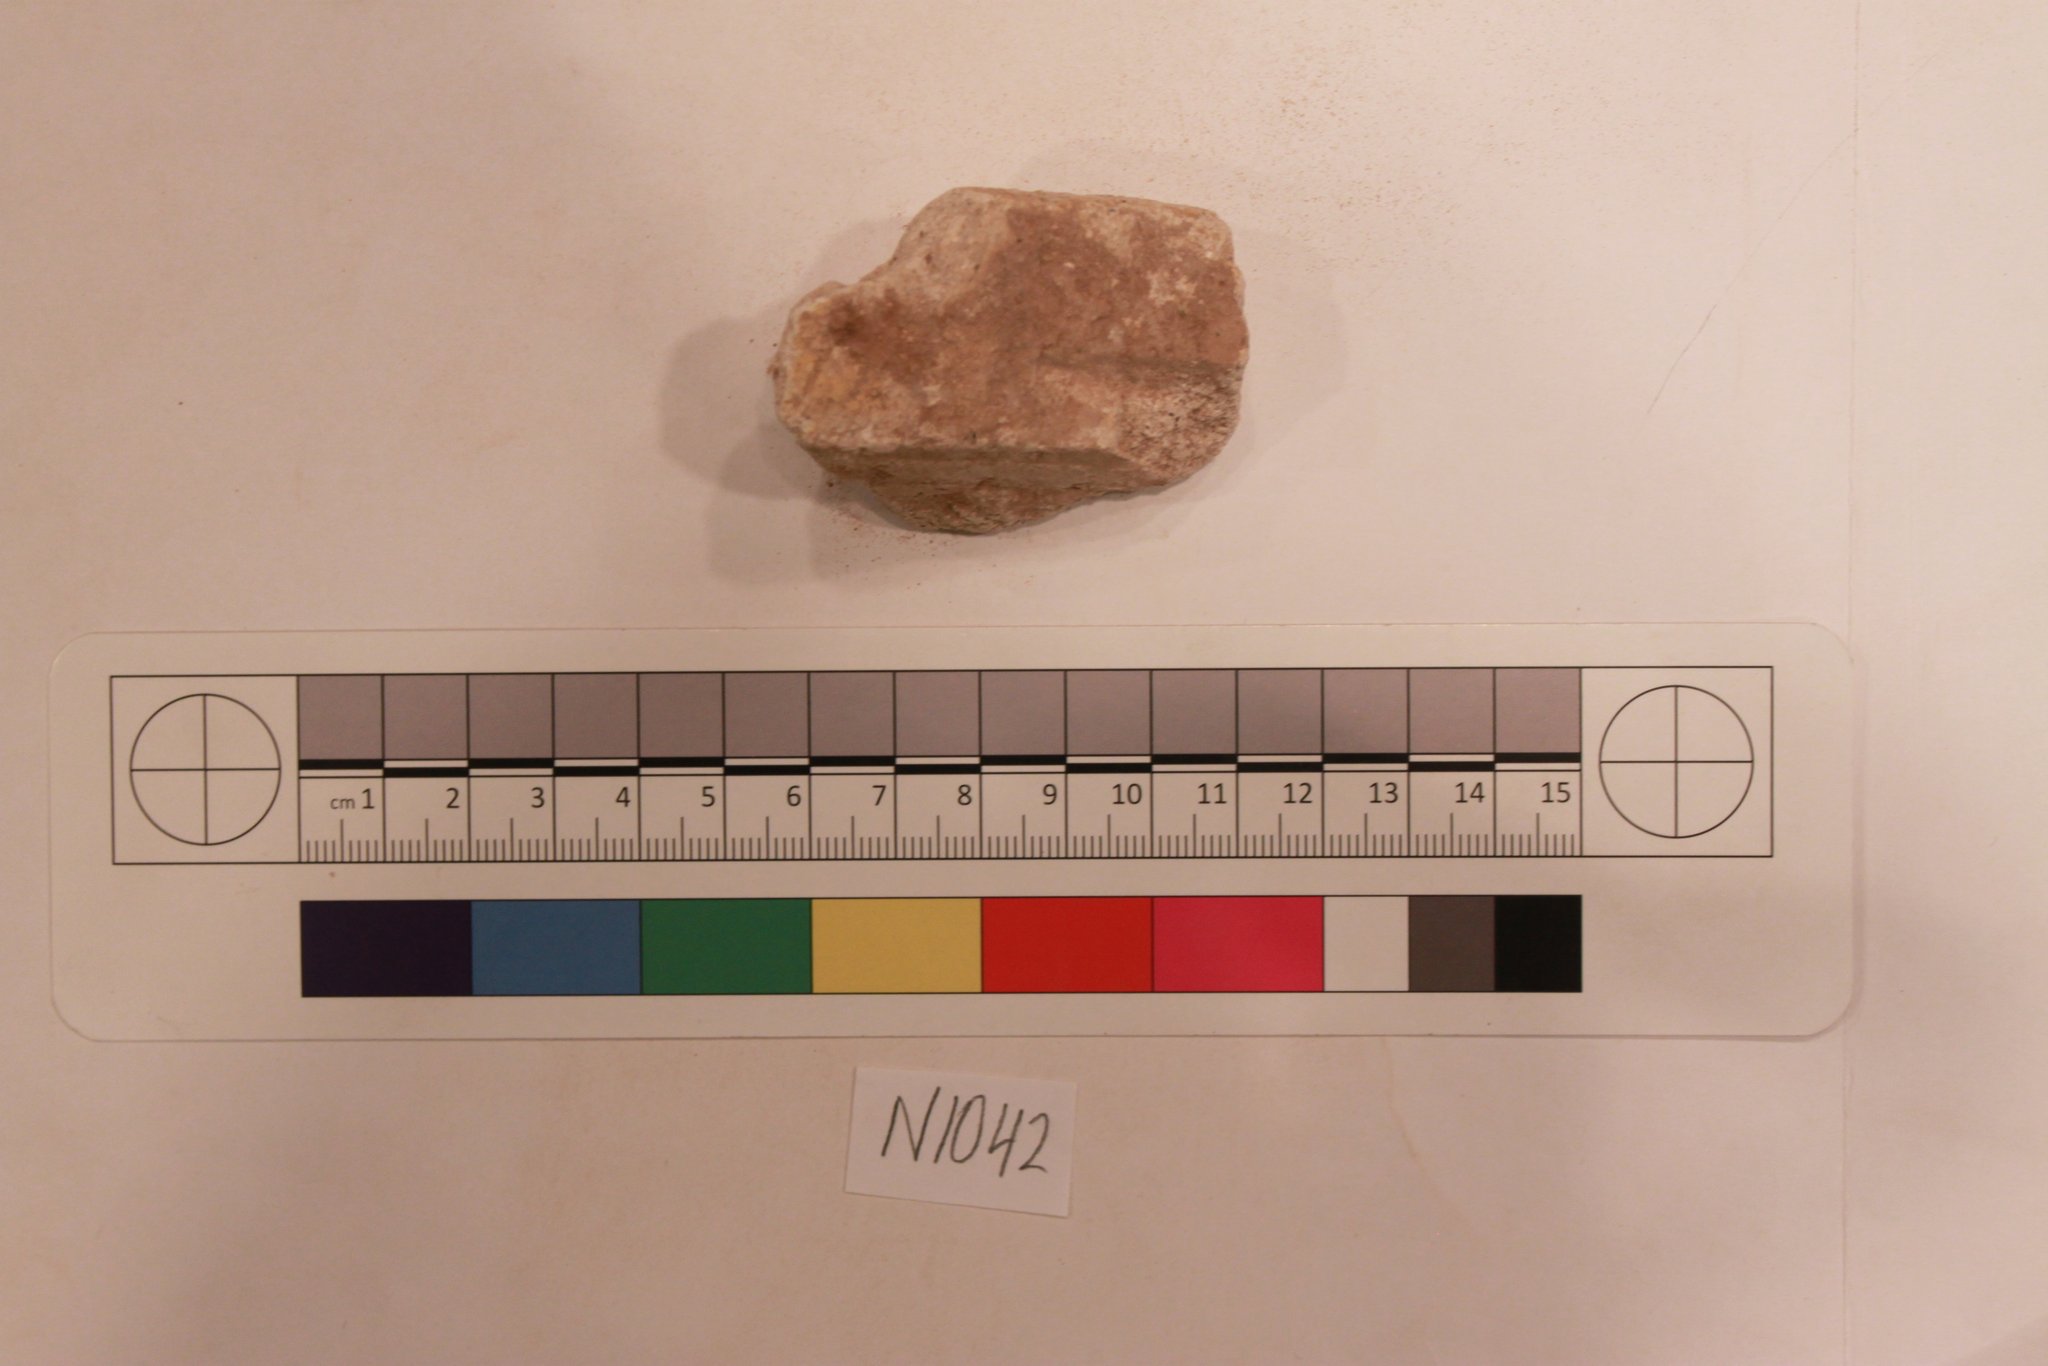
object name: fragment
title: Stucco Fragment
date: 701-1200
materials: plaster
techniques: carving, painting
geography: iran